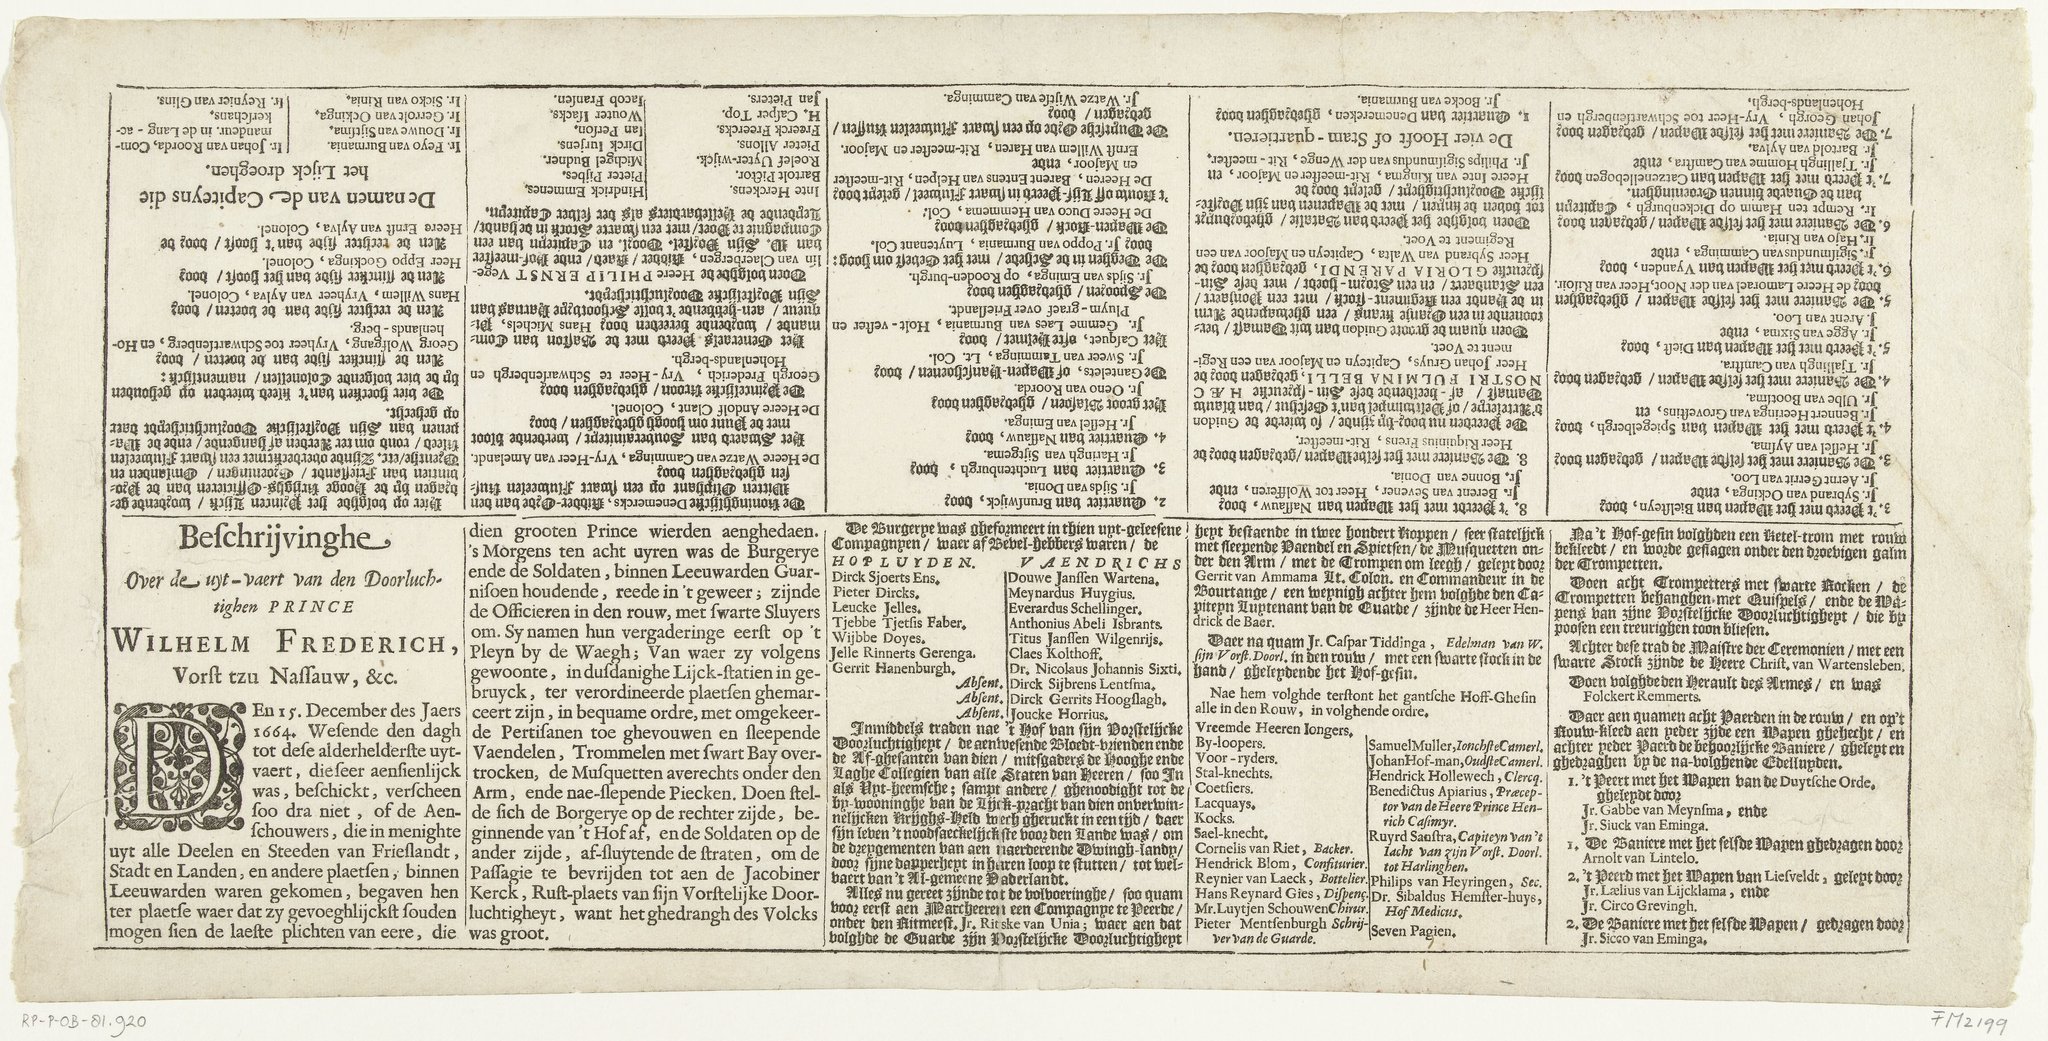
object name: text sheet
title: Rouw-Staetelijcke Lijk-pracht in de Uyt-Vaert en Begraefenisse van het ont-zielde Lichaem van (...) Wilhelm Frederich (...) Overleden binnen Leeuwarden (...) den een-en-twintichsten October, MDCLXIV. en aldaer in 't Choor van de Jacobijner Kerck, den vyfthienden december MDCLXIV. Oude Stijl (...)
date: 1666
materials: paper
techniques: letterpress printing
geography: leeuwarden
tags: arnhem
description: Begrafenisoptocht van Willem Frederik, graaf van Nassau-Dietz, in Leeuwarden op 6 januari 1665. Tekstblad met twee keer vijf kolommen tekst. Eerste tekstblad in een ensemble van 25 ongemonteerde genummerde platen en twee tekstbladen die samen een lange fries vormen.